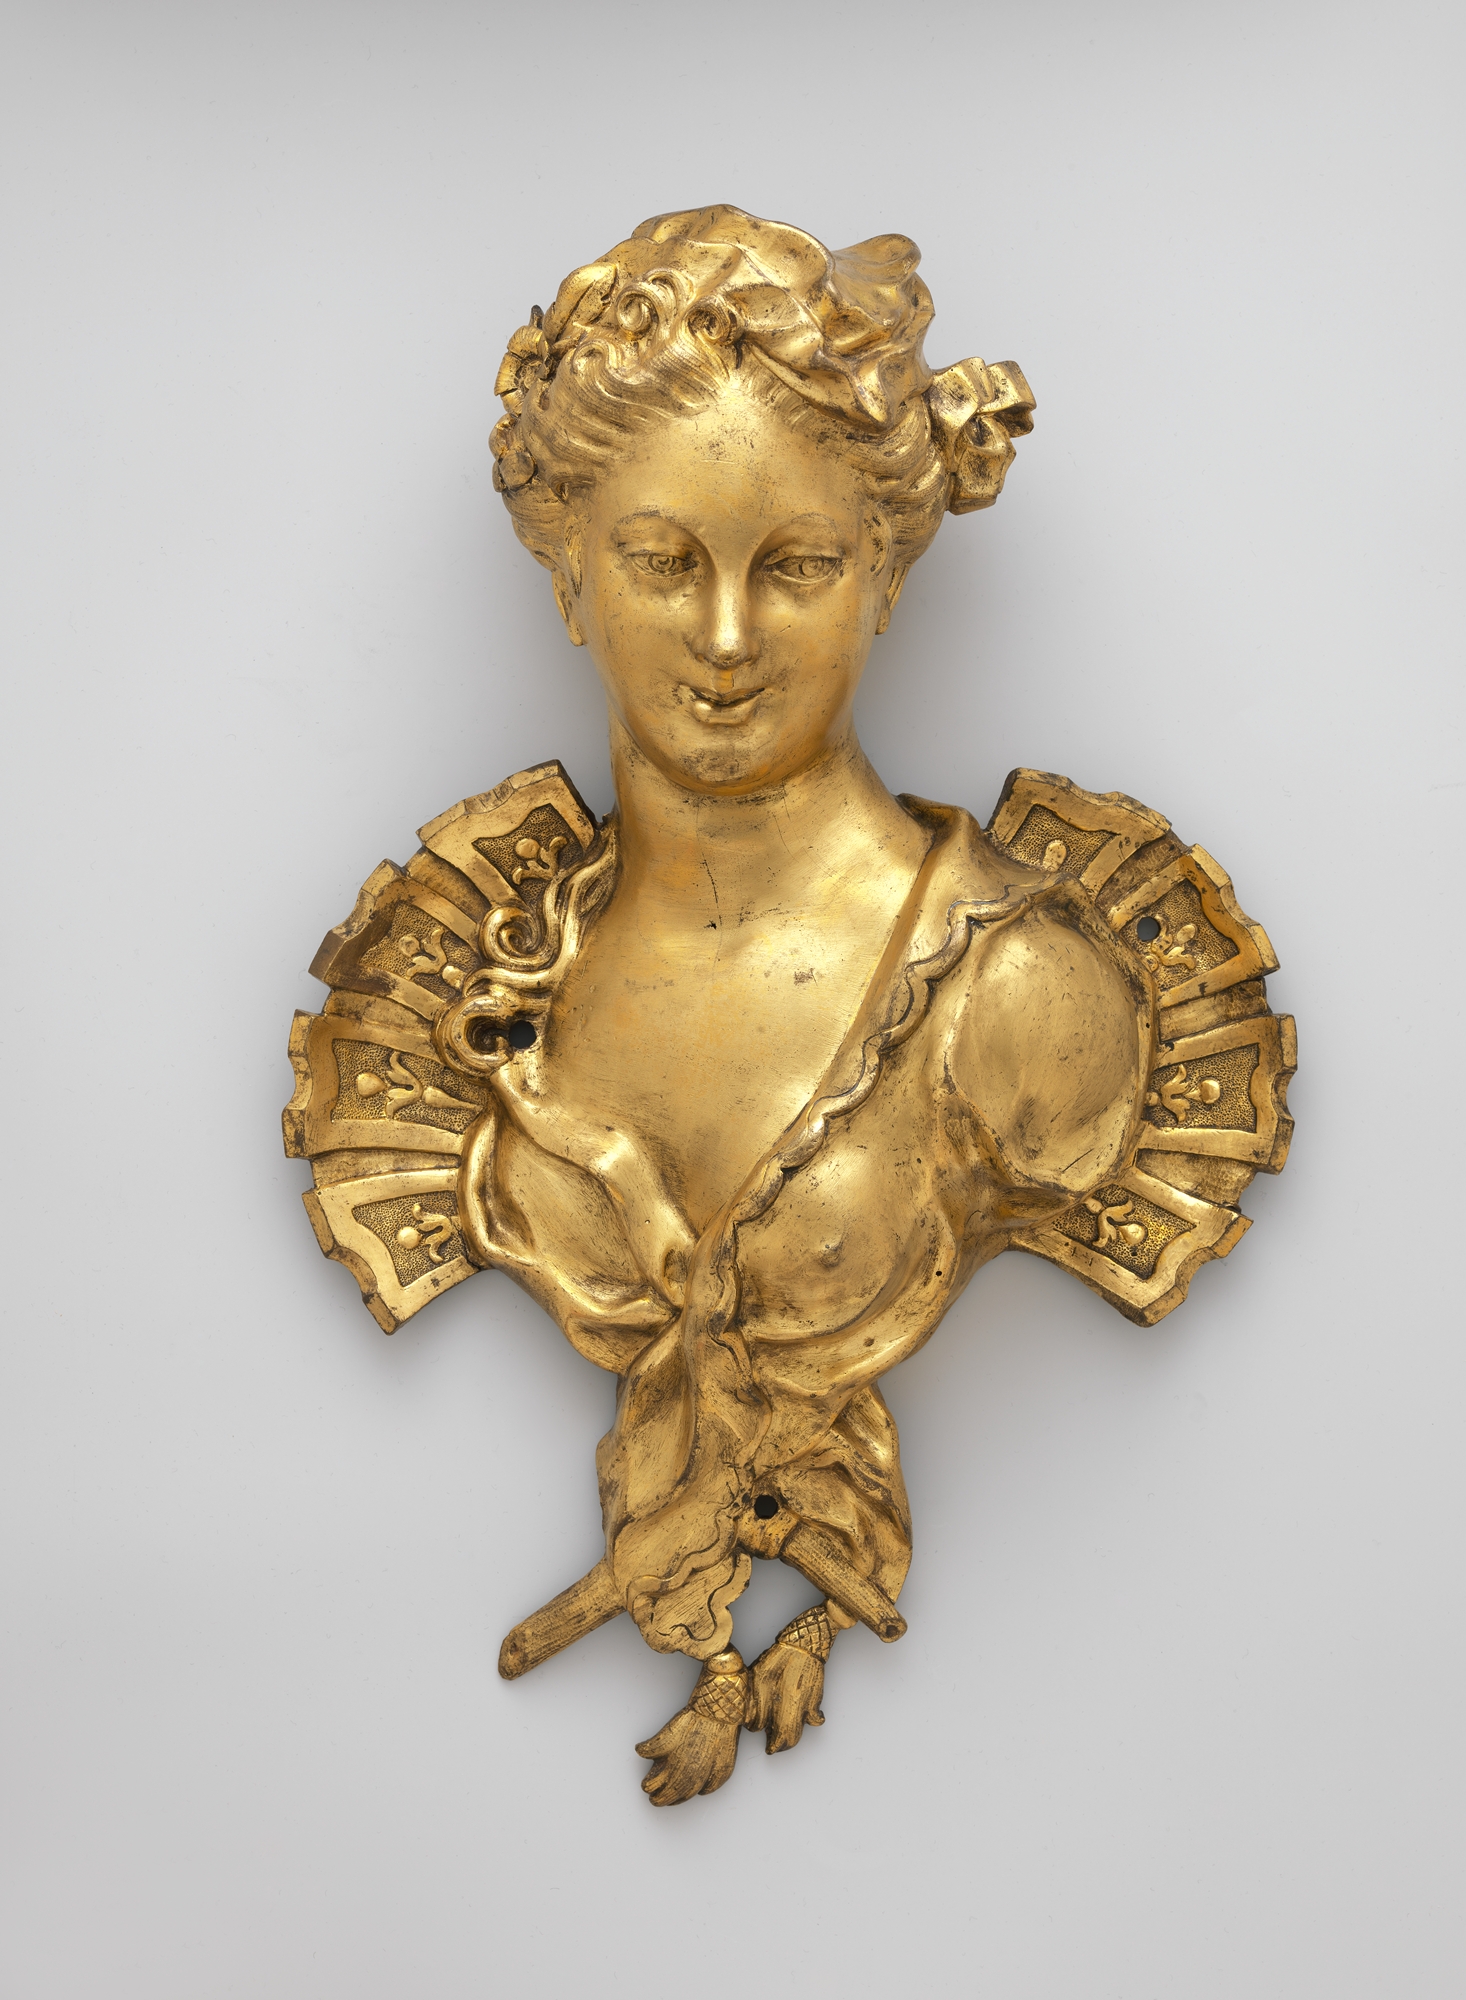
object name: bust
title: Female bust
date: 1725-1750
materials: gilt bronze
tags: women